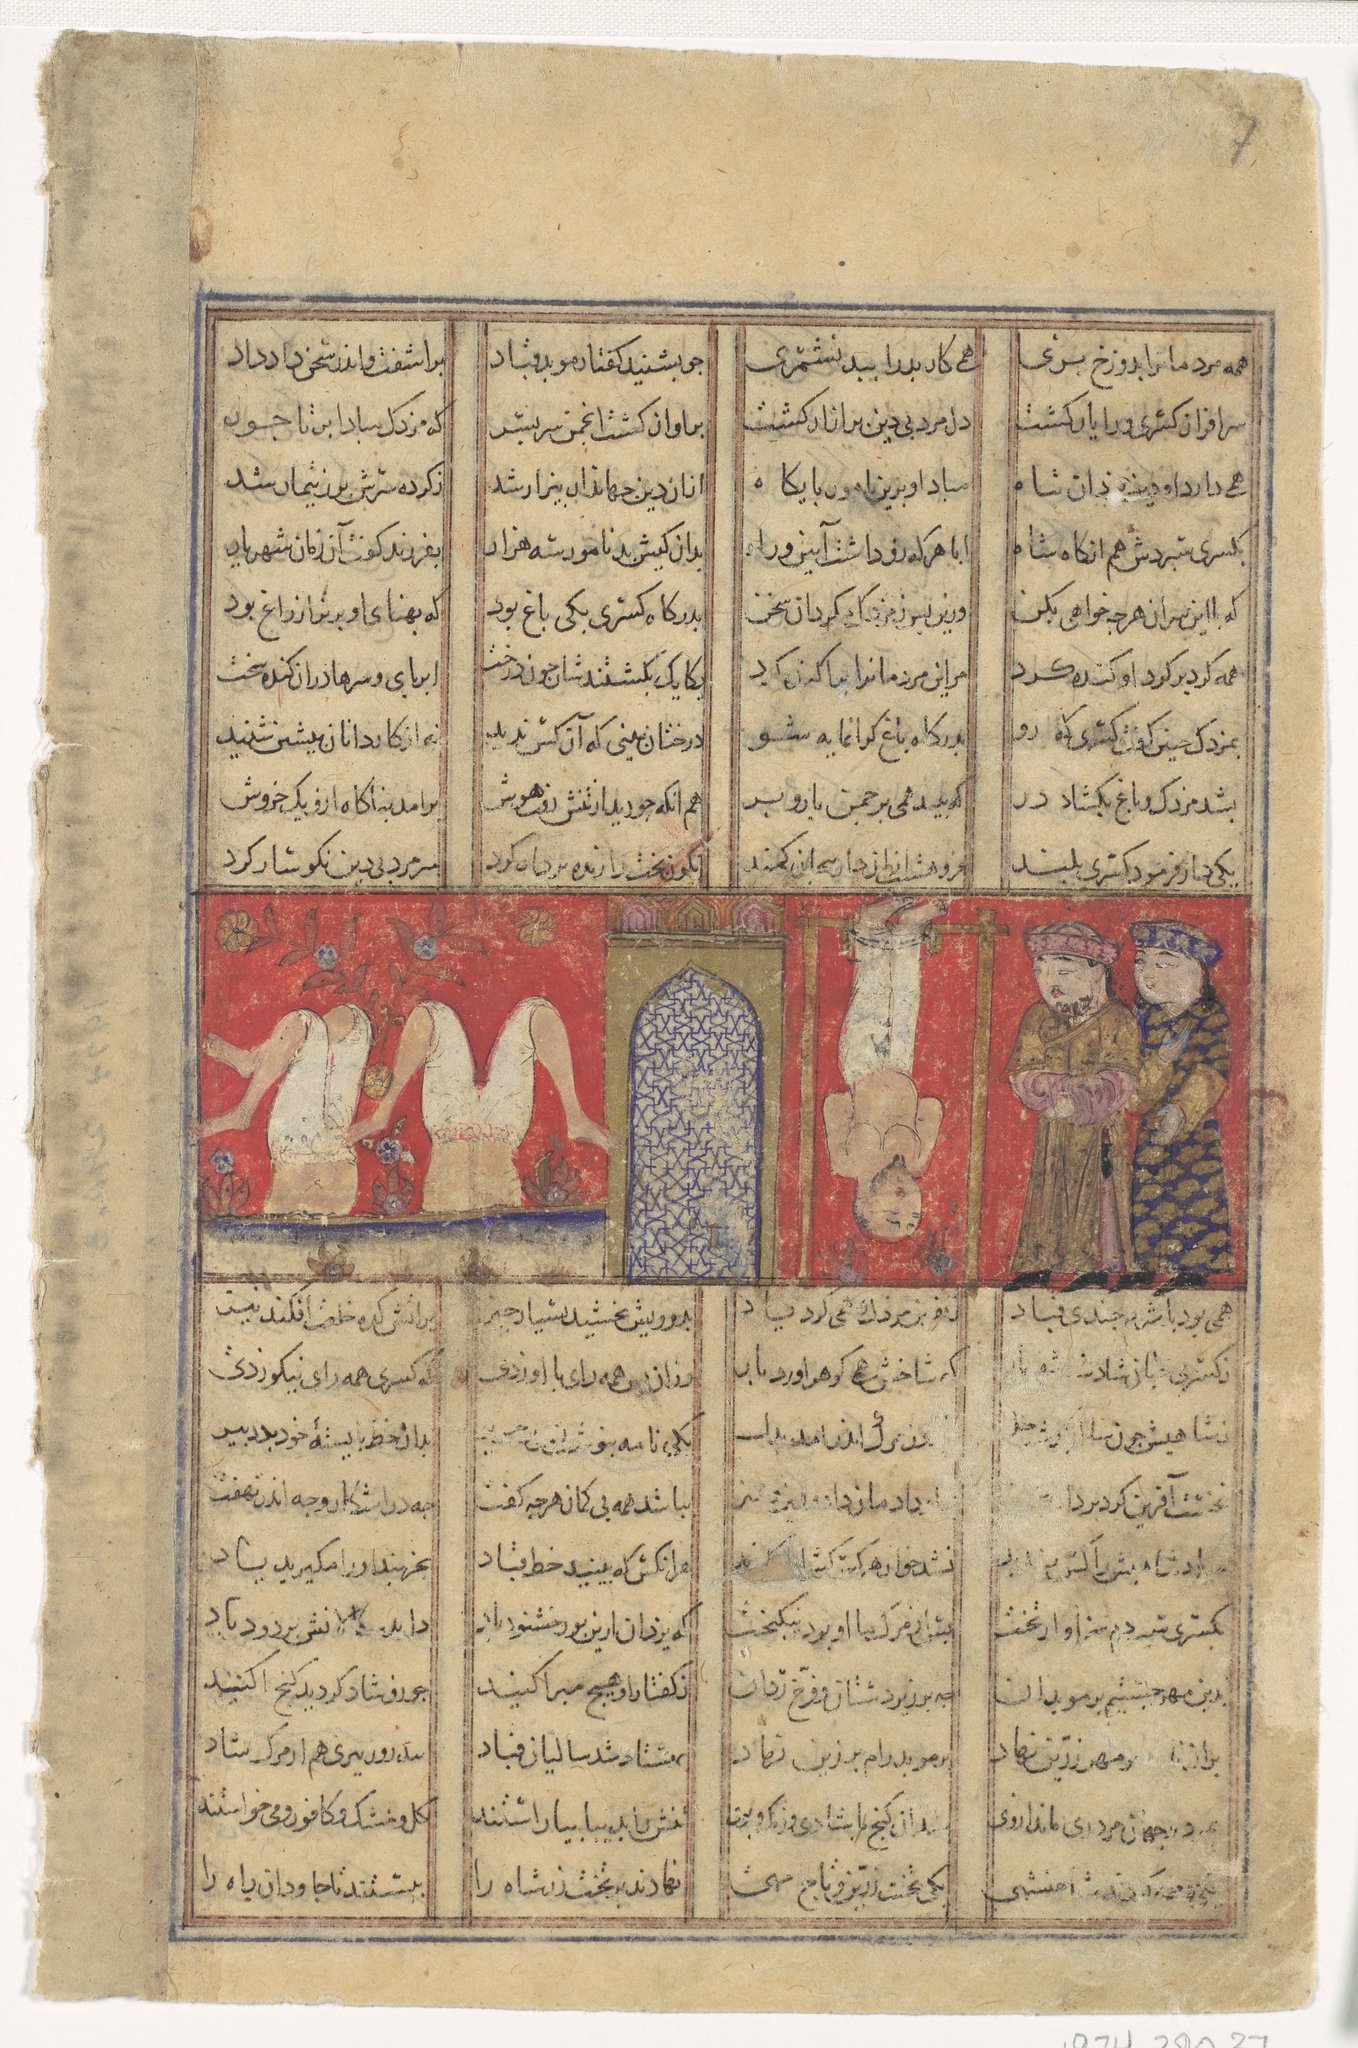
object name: folio from an illustrated manuscript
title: "The Execution of Mazdak", Folio from a Shahnama (Book of Kings)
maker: abu'l qasim firdausi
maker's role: author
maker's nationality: iranian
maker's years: 935-1020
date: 1330-1340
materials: gold, ink, paper, silver, watercolor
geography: iran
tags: men,women,execution